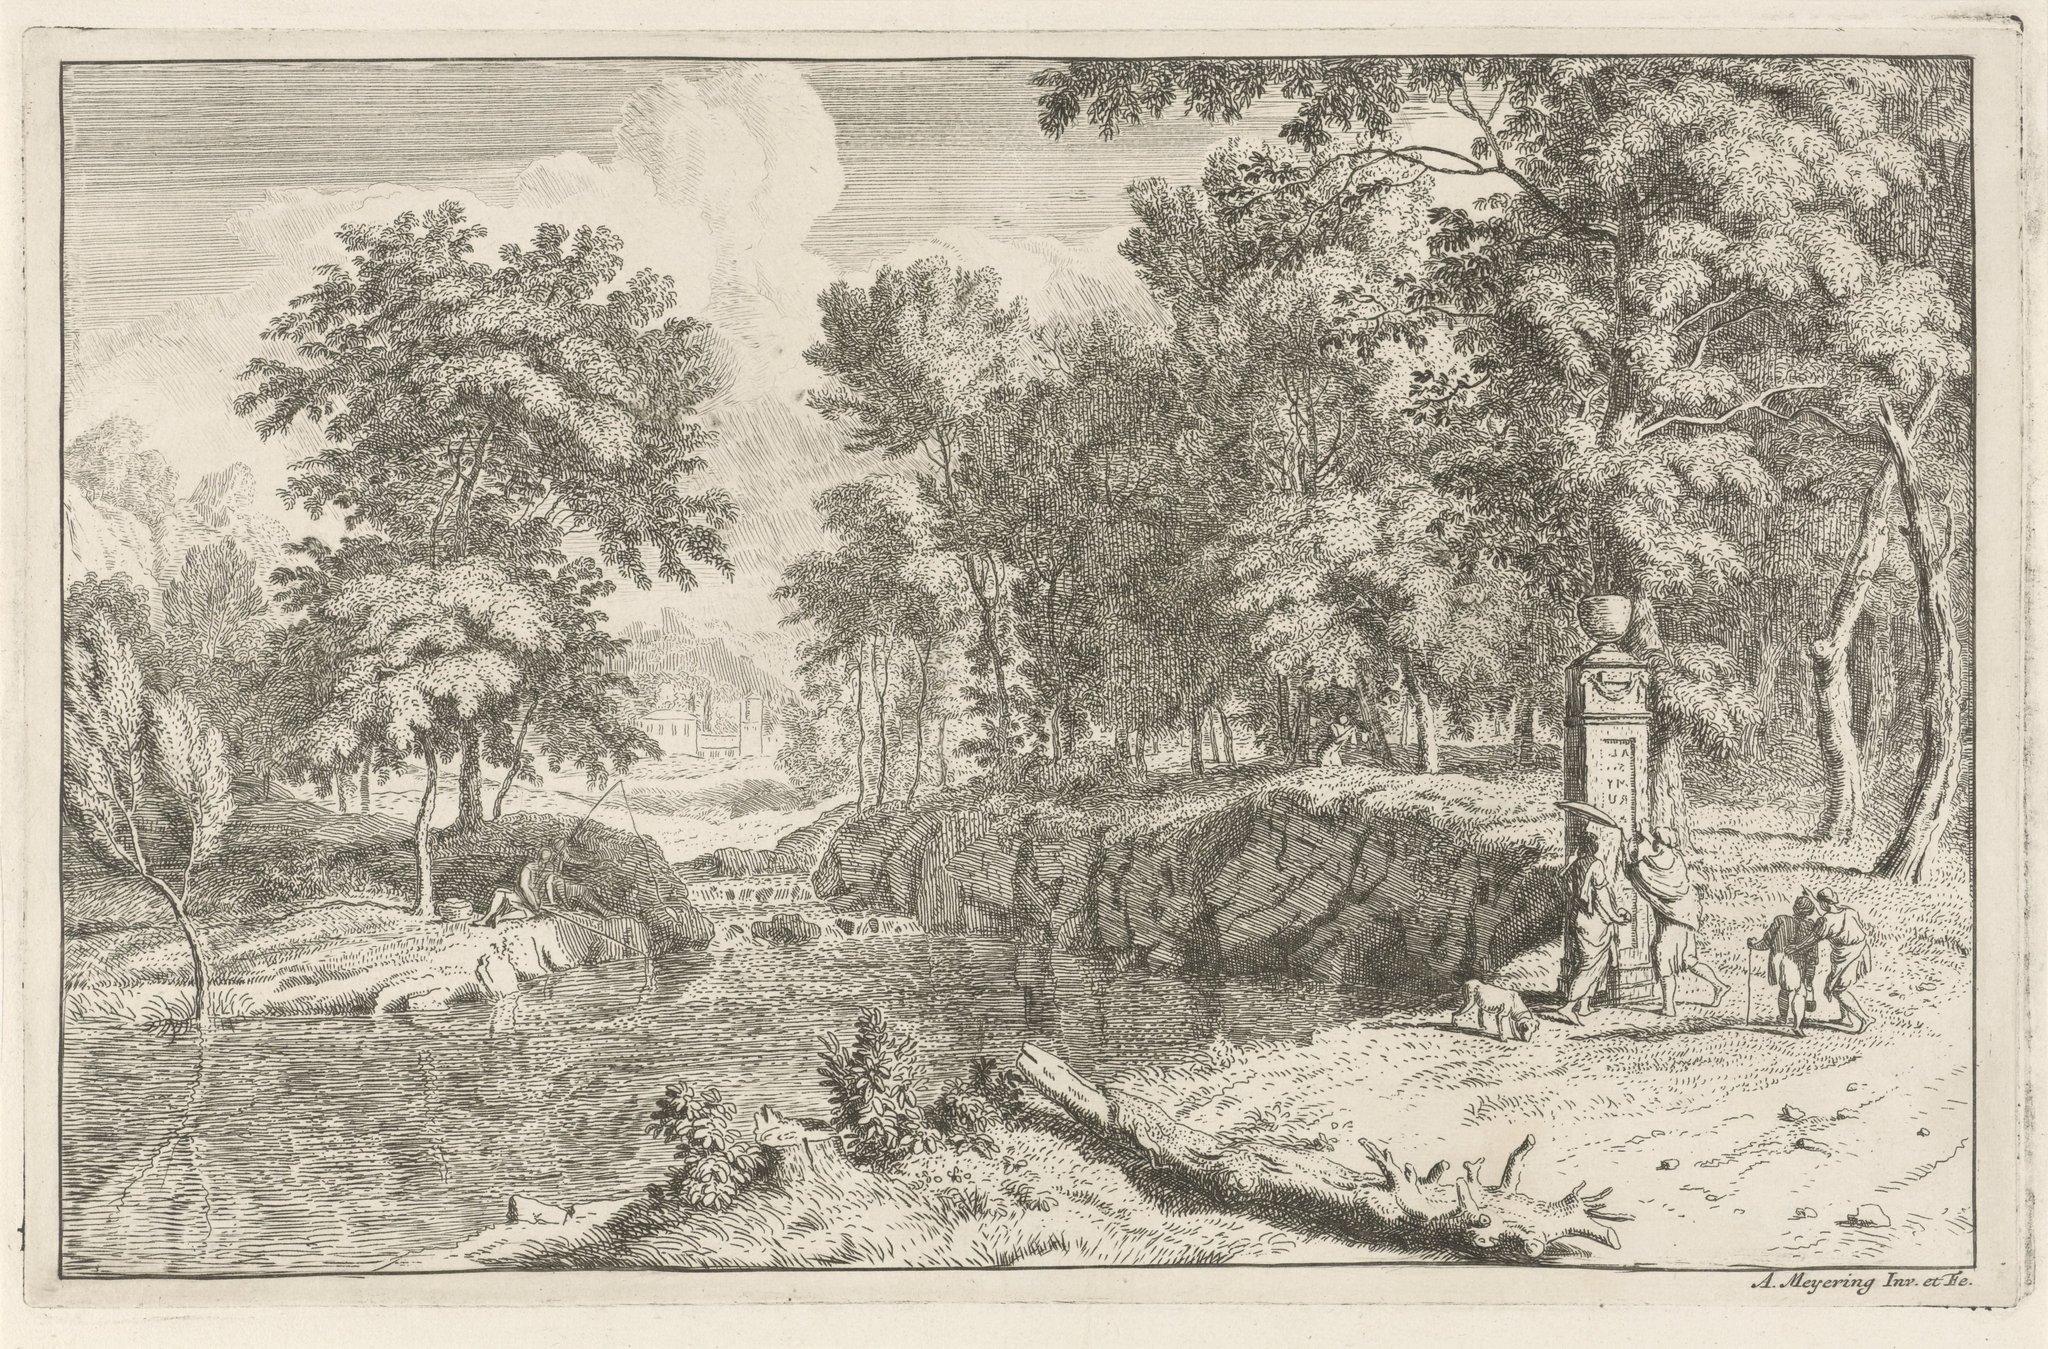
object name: print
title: Landschap met vier mensen bij een monument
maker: albert meyering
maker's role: draughtsman, print maker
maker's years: 1645-1714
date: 1665-1714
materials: paper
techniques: etching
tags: inscription, forest, wood, brook, angling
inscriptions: collector's mark: Lugt 2228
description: Beek met beboste oevers. Links twee hengelaars bij de beek. Rechts vier mensen bij een monument met inscriptie.